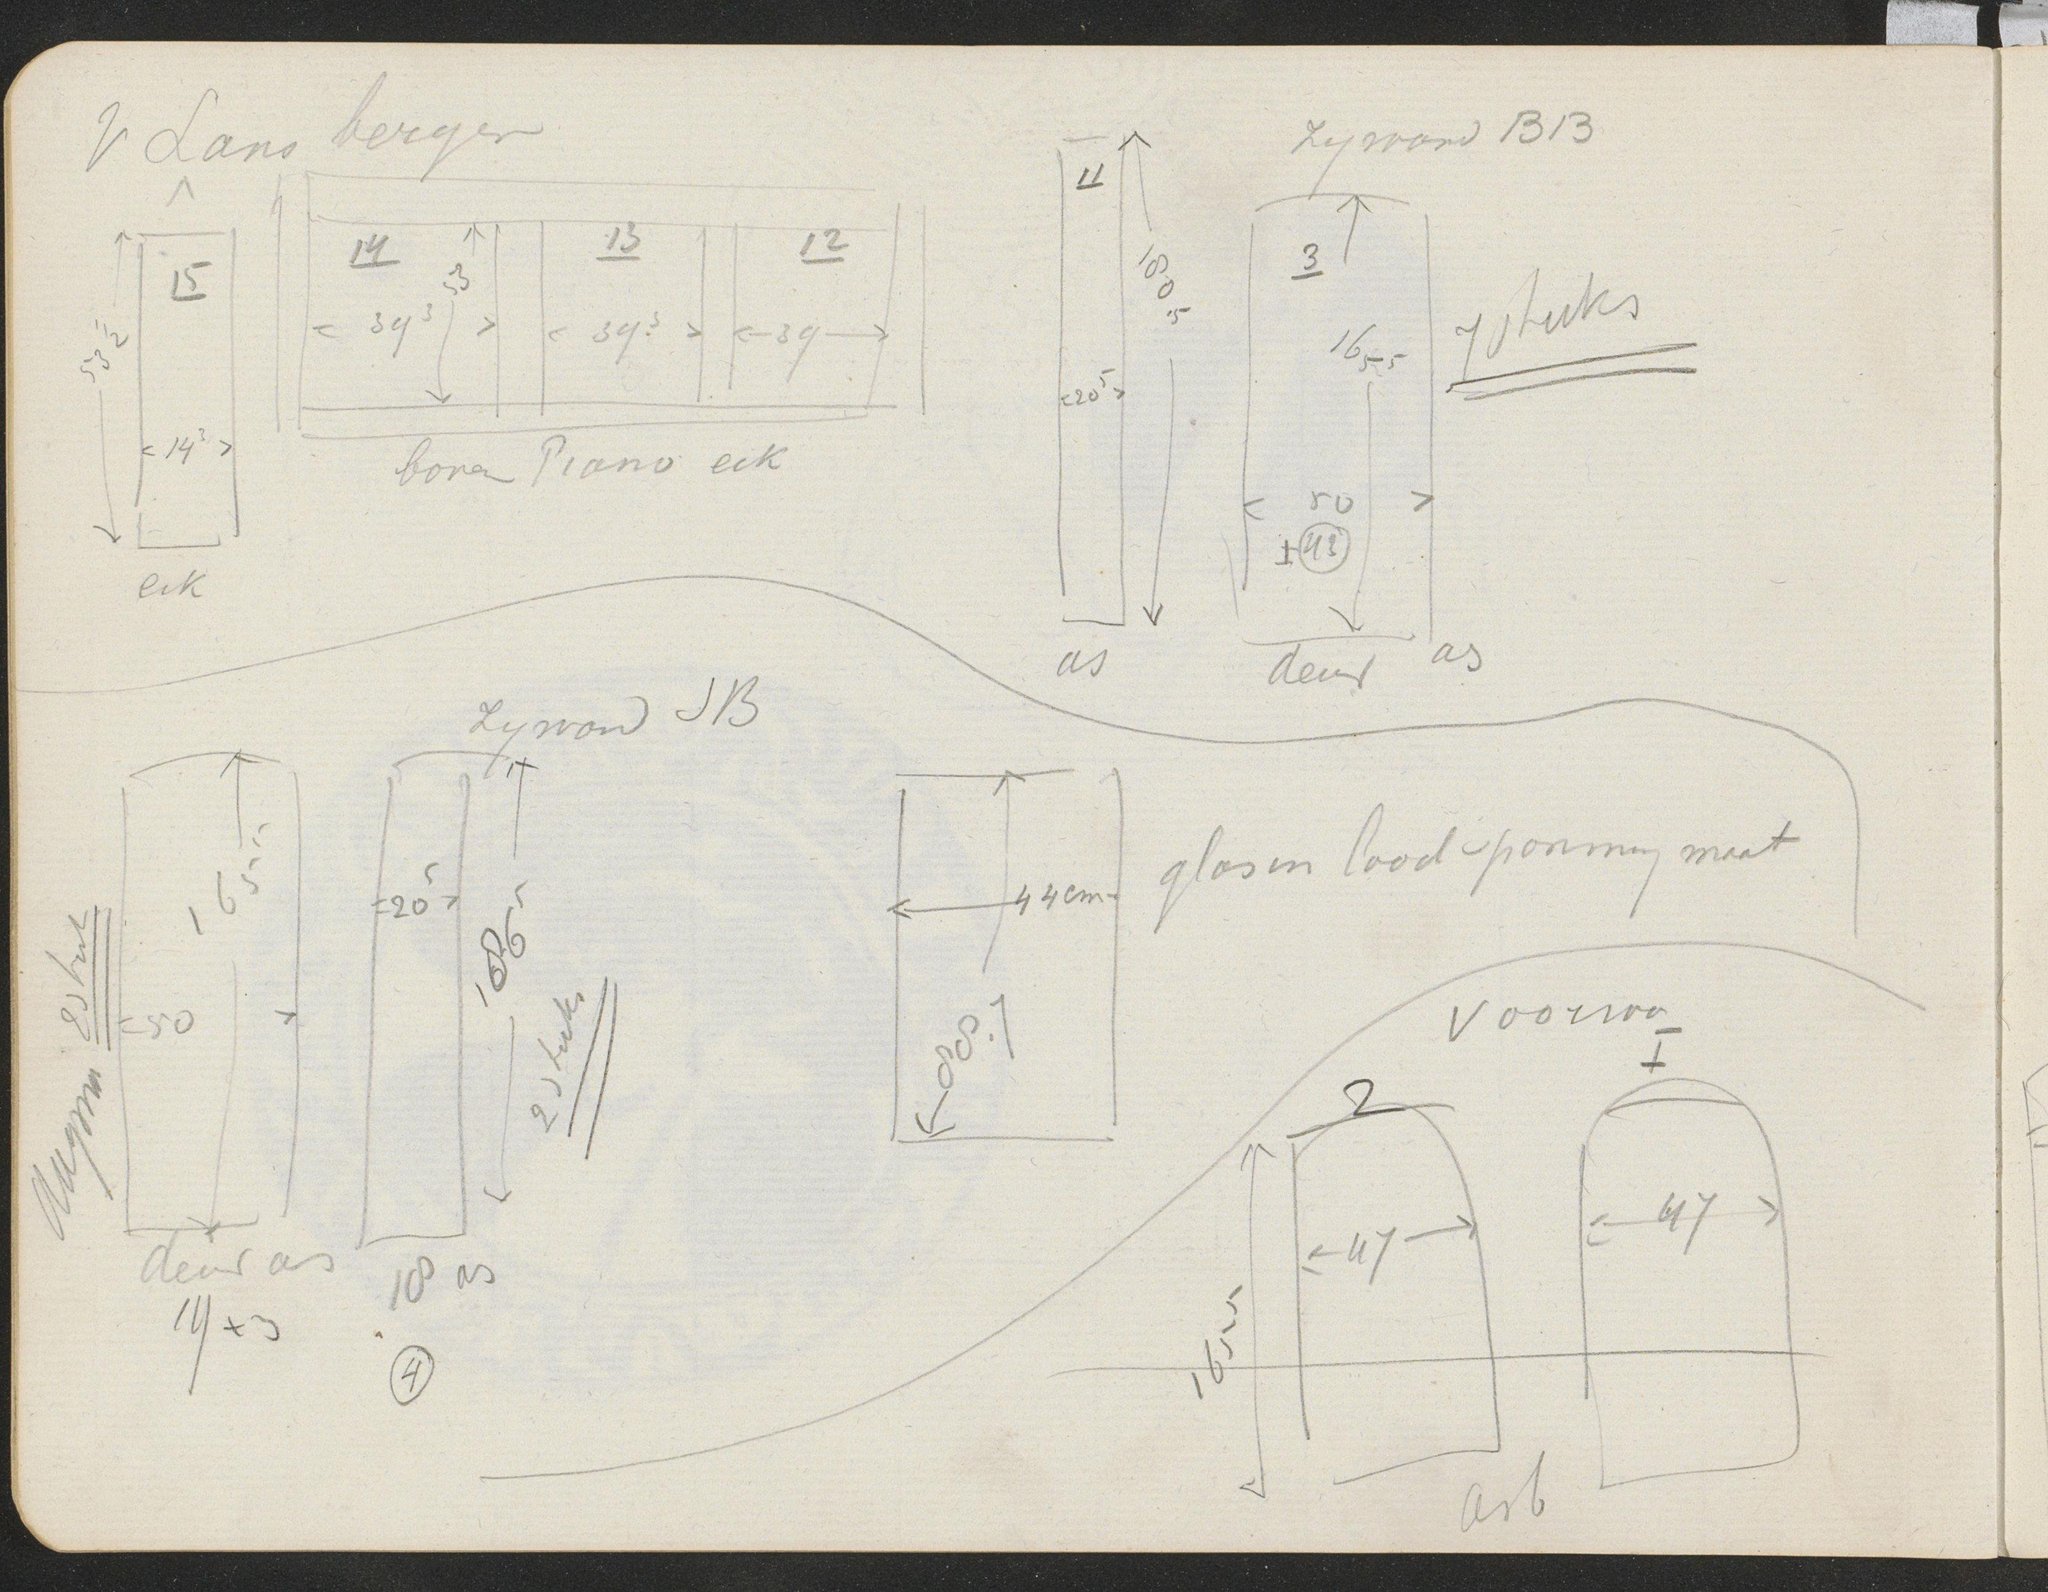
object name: sketchbook leaf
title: Ontwerpen voor deuren en zijwanden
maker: carel adolph lion cachet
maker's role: draughtsman, print maker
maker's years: 1864-1945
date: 1905-1910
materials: paper, pencil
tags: architecture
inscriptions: annotation: ‘[...]’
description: Blad 8 verso uit een schetsboek met 27 bladen.